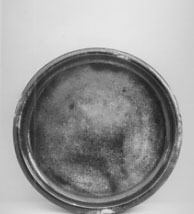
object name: plate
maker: ernest chaplet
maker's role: designer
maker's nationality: french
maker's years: 1835-1909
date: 1890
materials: porcelain